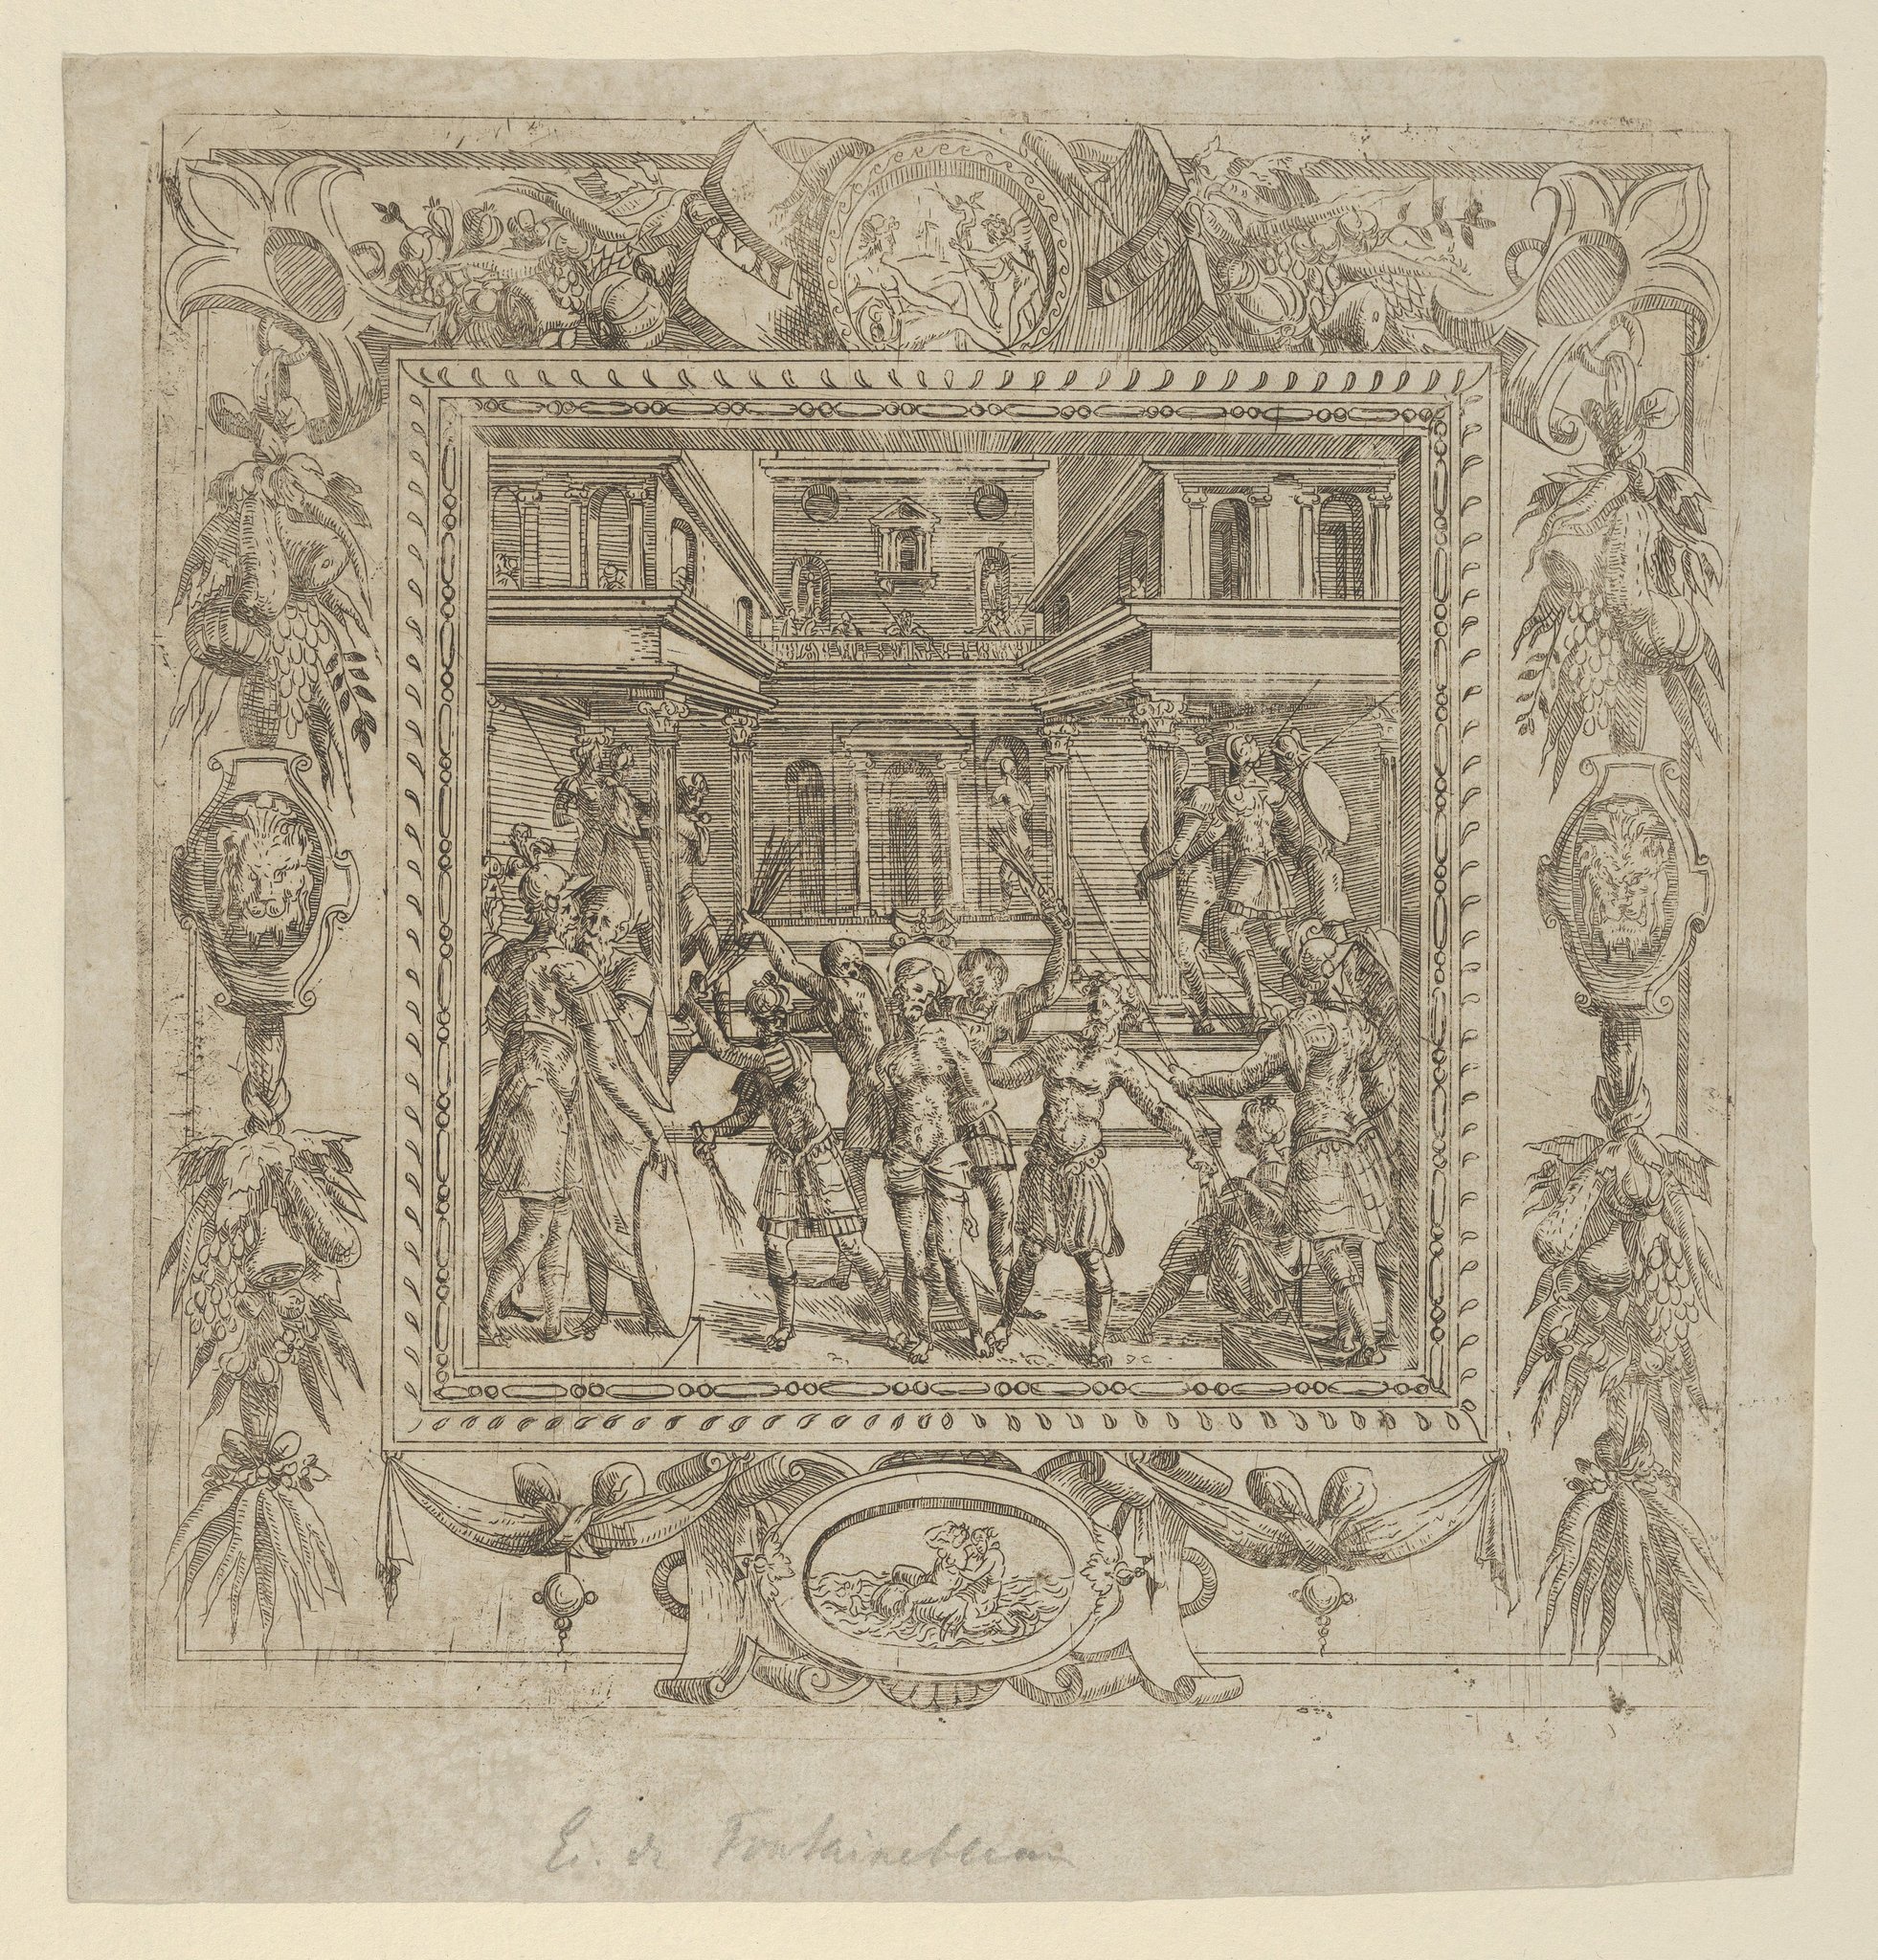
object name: print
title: Flagellation of Christ in an ornate Frame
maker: anonymous, french, school of fontainebleau, 16th century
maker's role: etcher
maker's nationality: french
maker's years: 1500-1600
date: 1542-1545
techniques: etching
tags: soldiers,men,christ